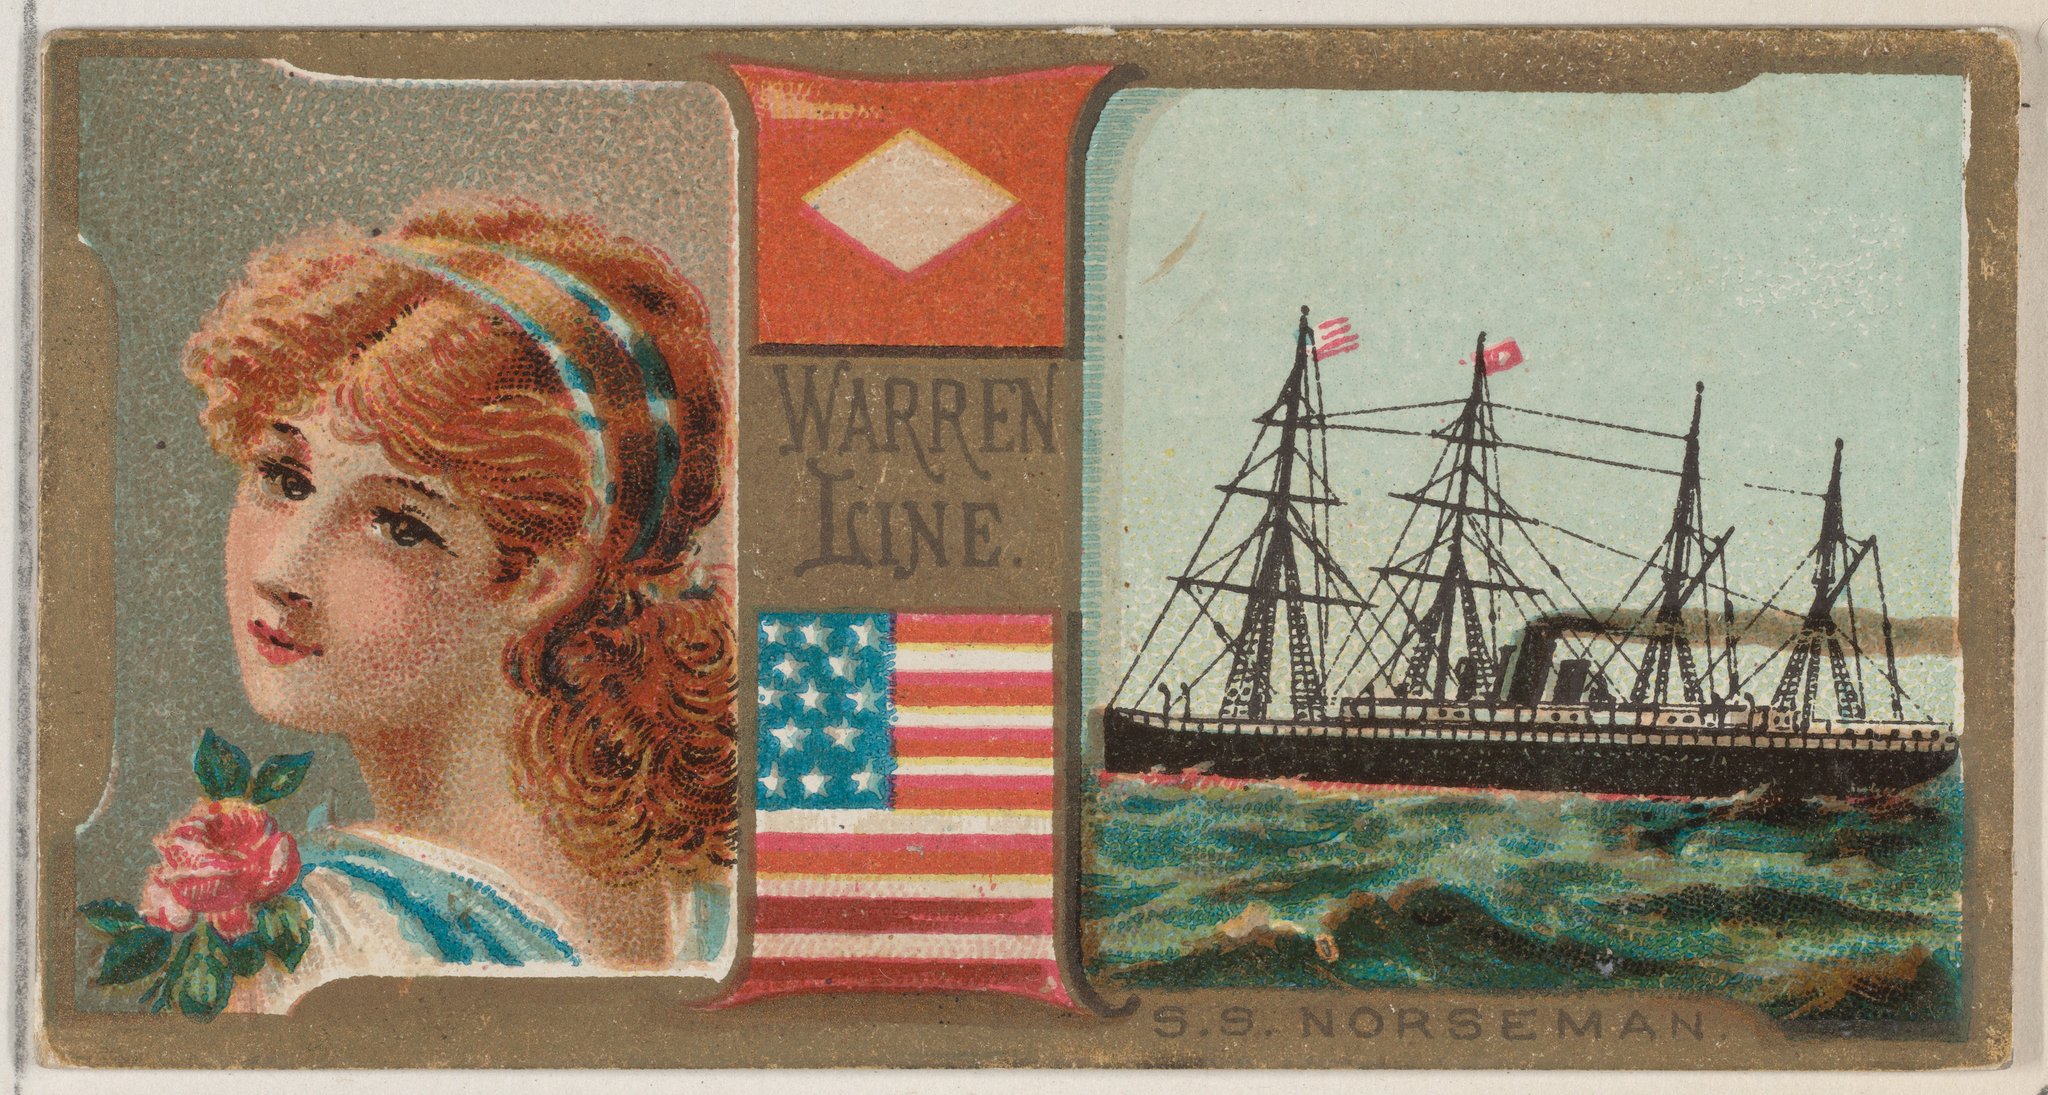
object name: print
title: Steamship Norseman, Warren Line, from the Ocean and River Steamers series (N83) for Duke brand cigarettes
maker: w. duke, sons & co.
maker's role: publisher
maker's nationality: american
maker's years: 1870-1920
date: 1887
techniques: color lithograph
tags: women,ships